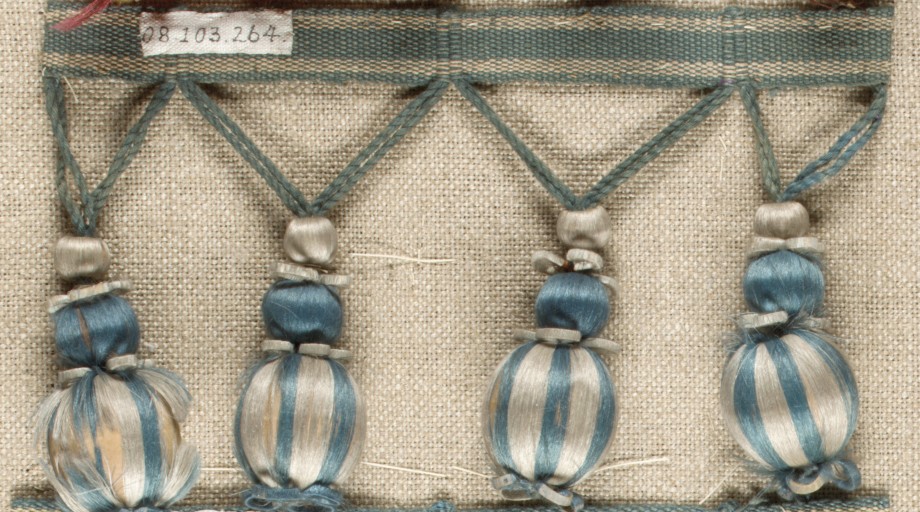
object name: fringe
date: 1801-1900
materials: cotton, silk